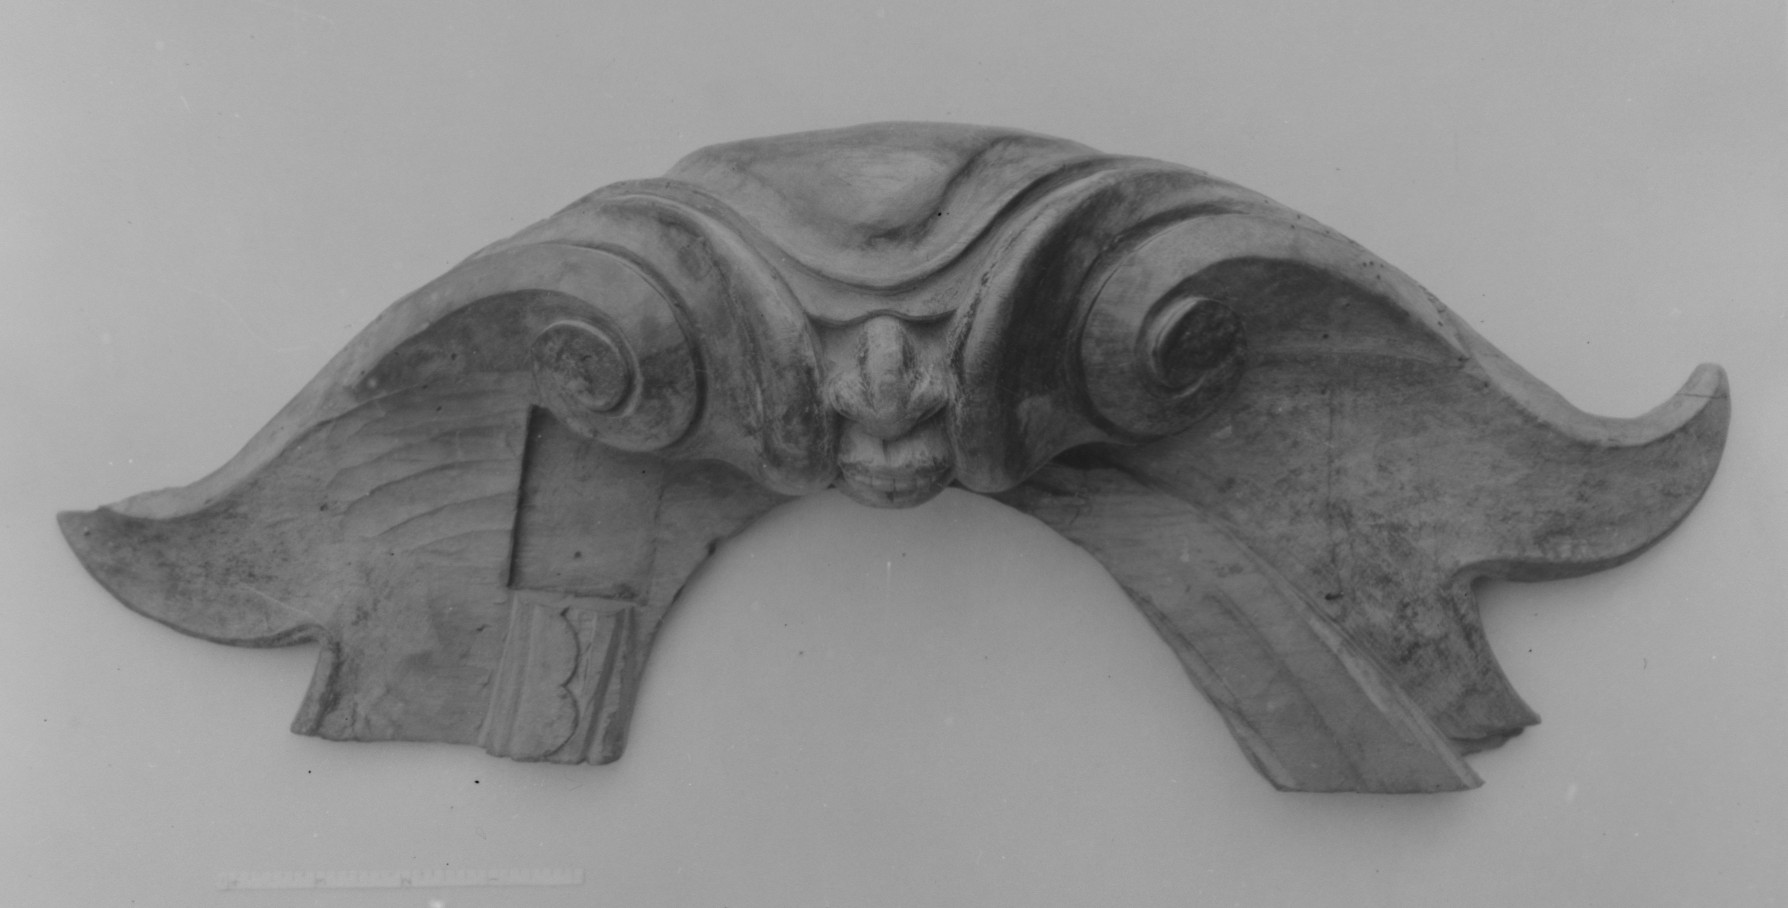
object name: stall fragment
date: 1601-1700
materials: wood